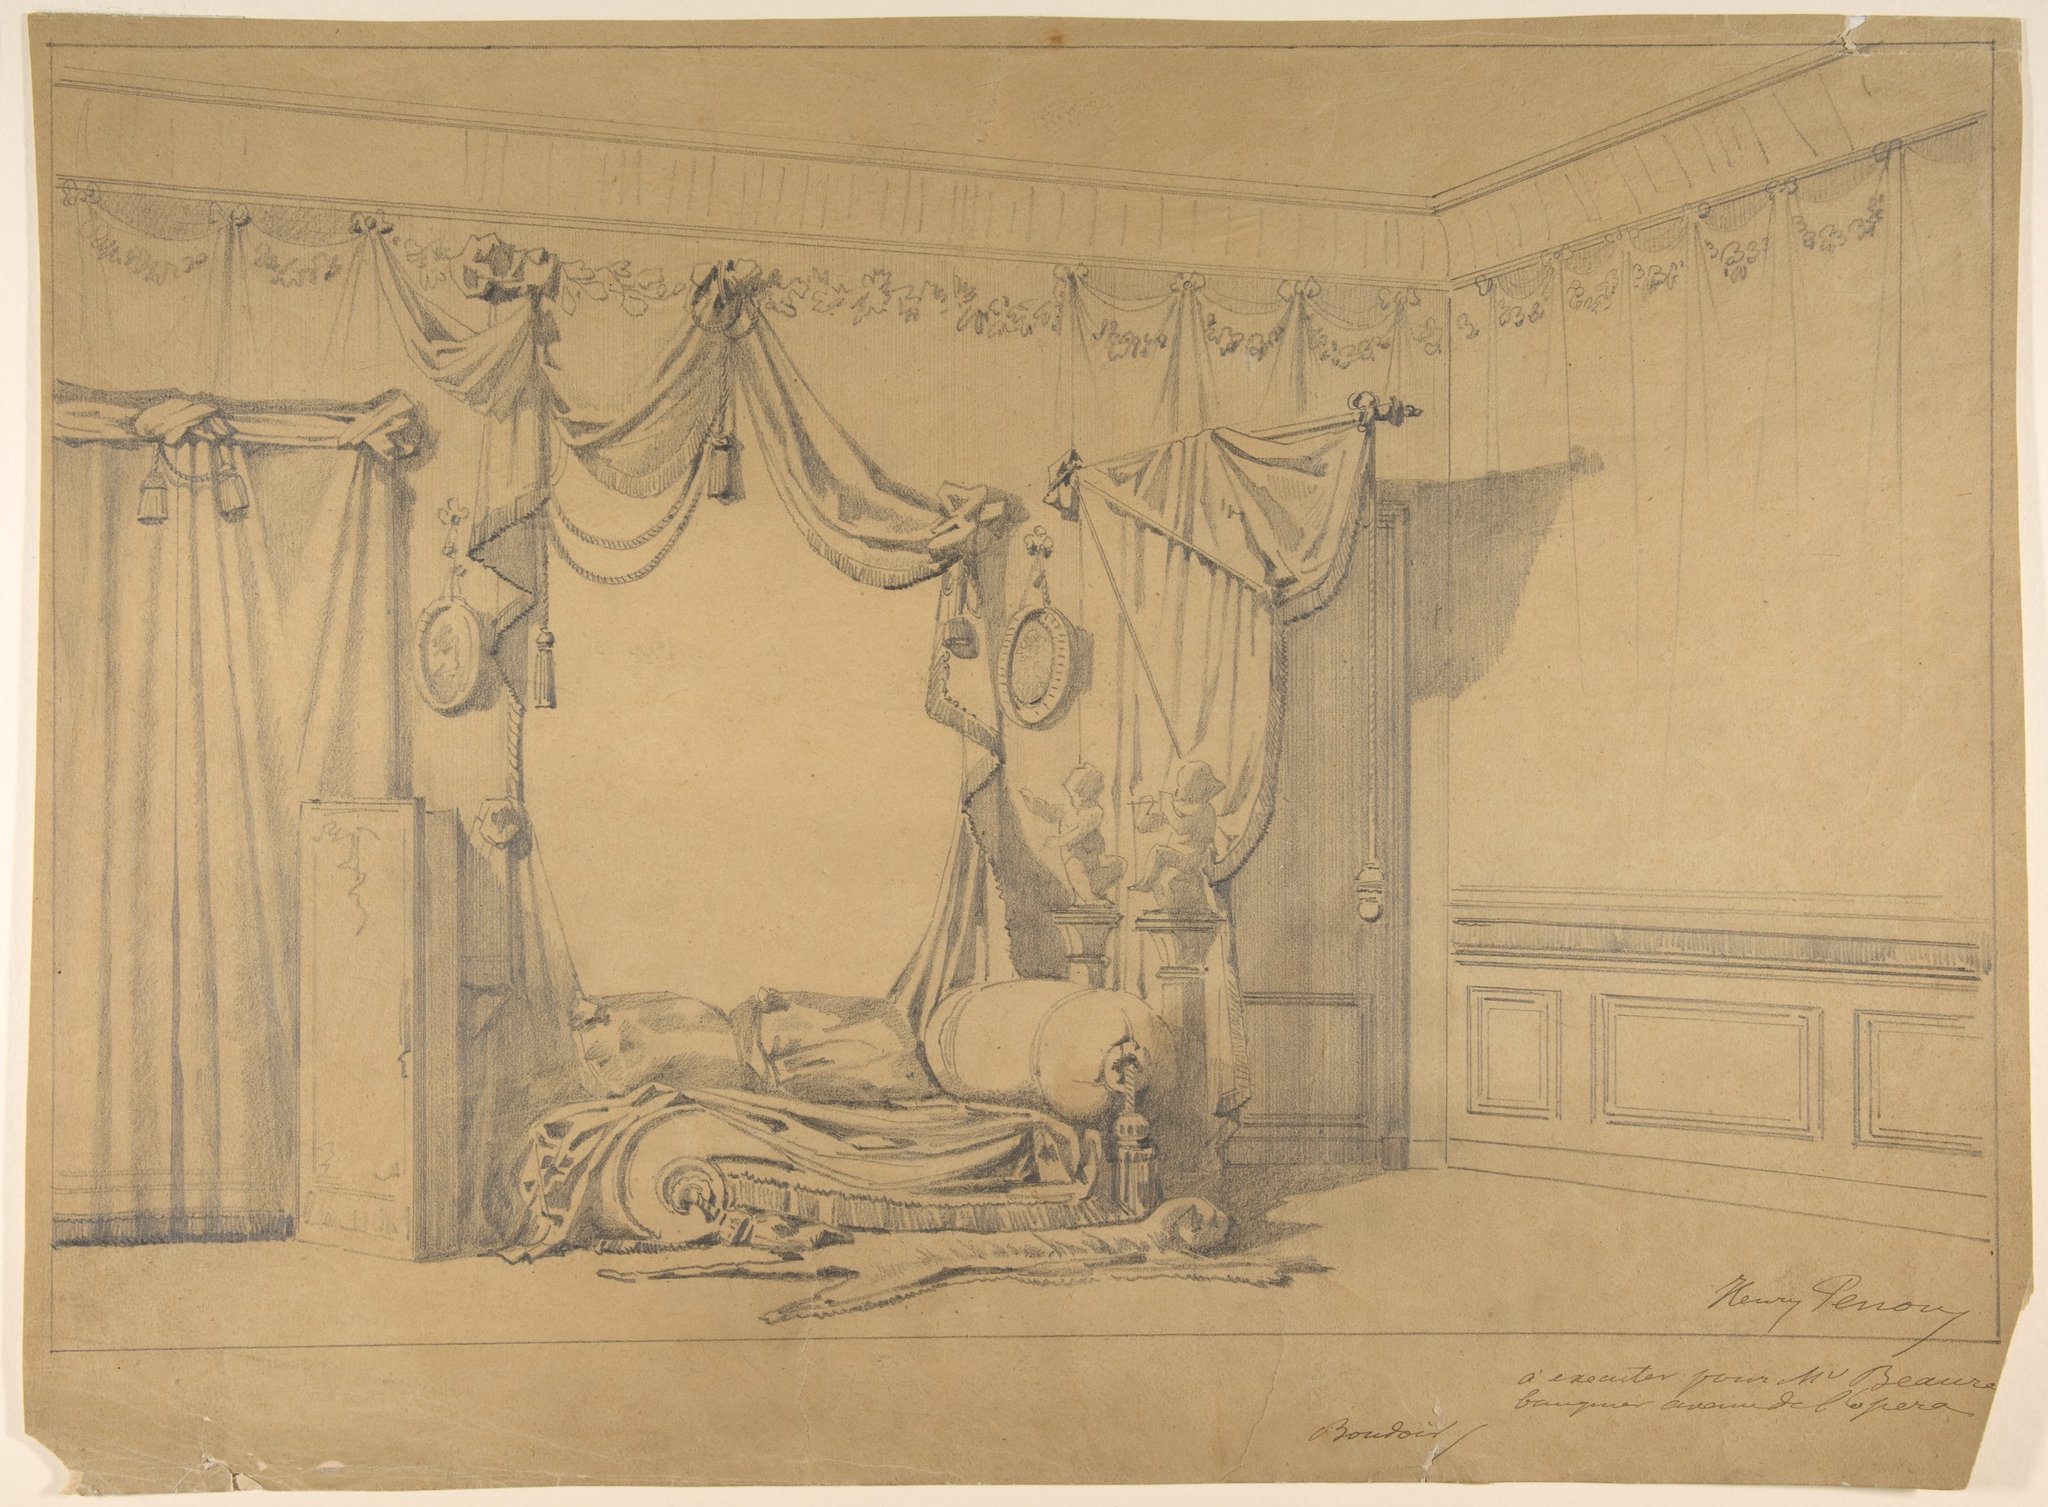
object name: drawing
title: Design for a bedroom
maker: henri perron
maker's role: artist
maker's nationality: french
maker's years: 1800-1899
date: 1801-1900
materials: graphite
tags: architecture,bedrooms,curtains